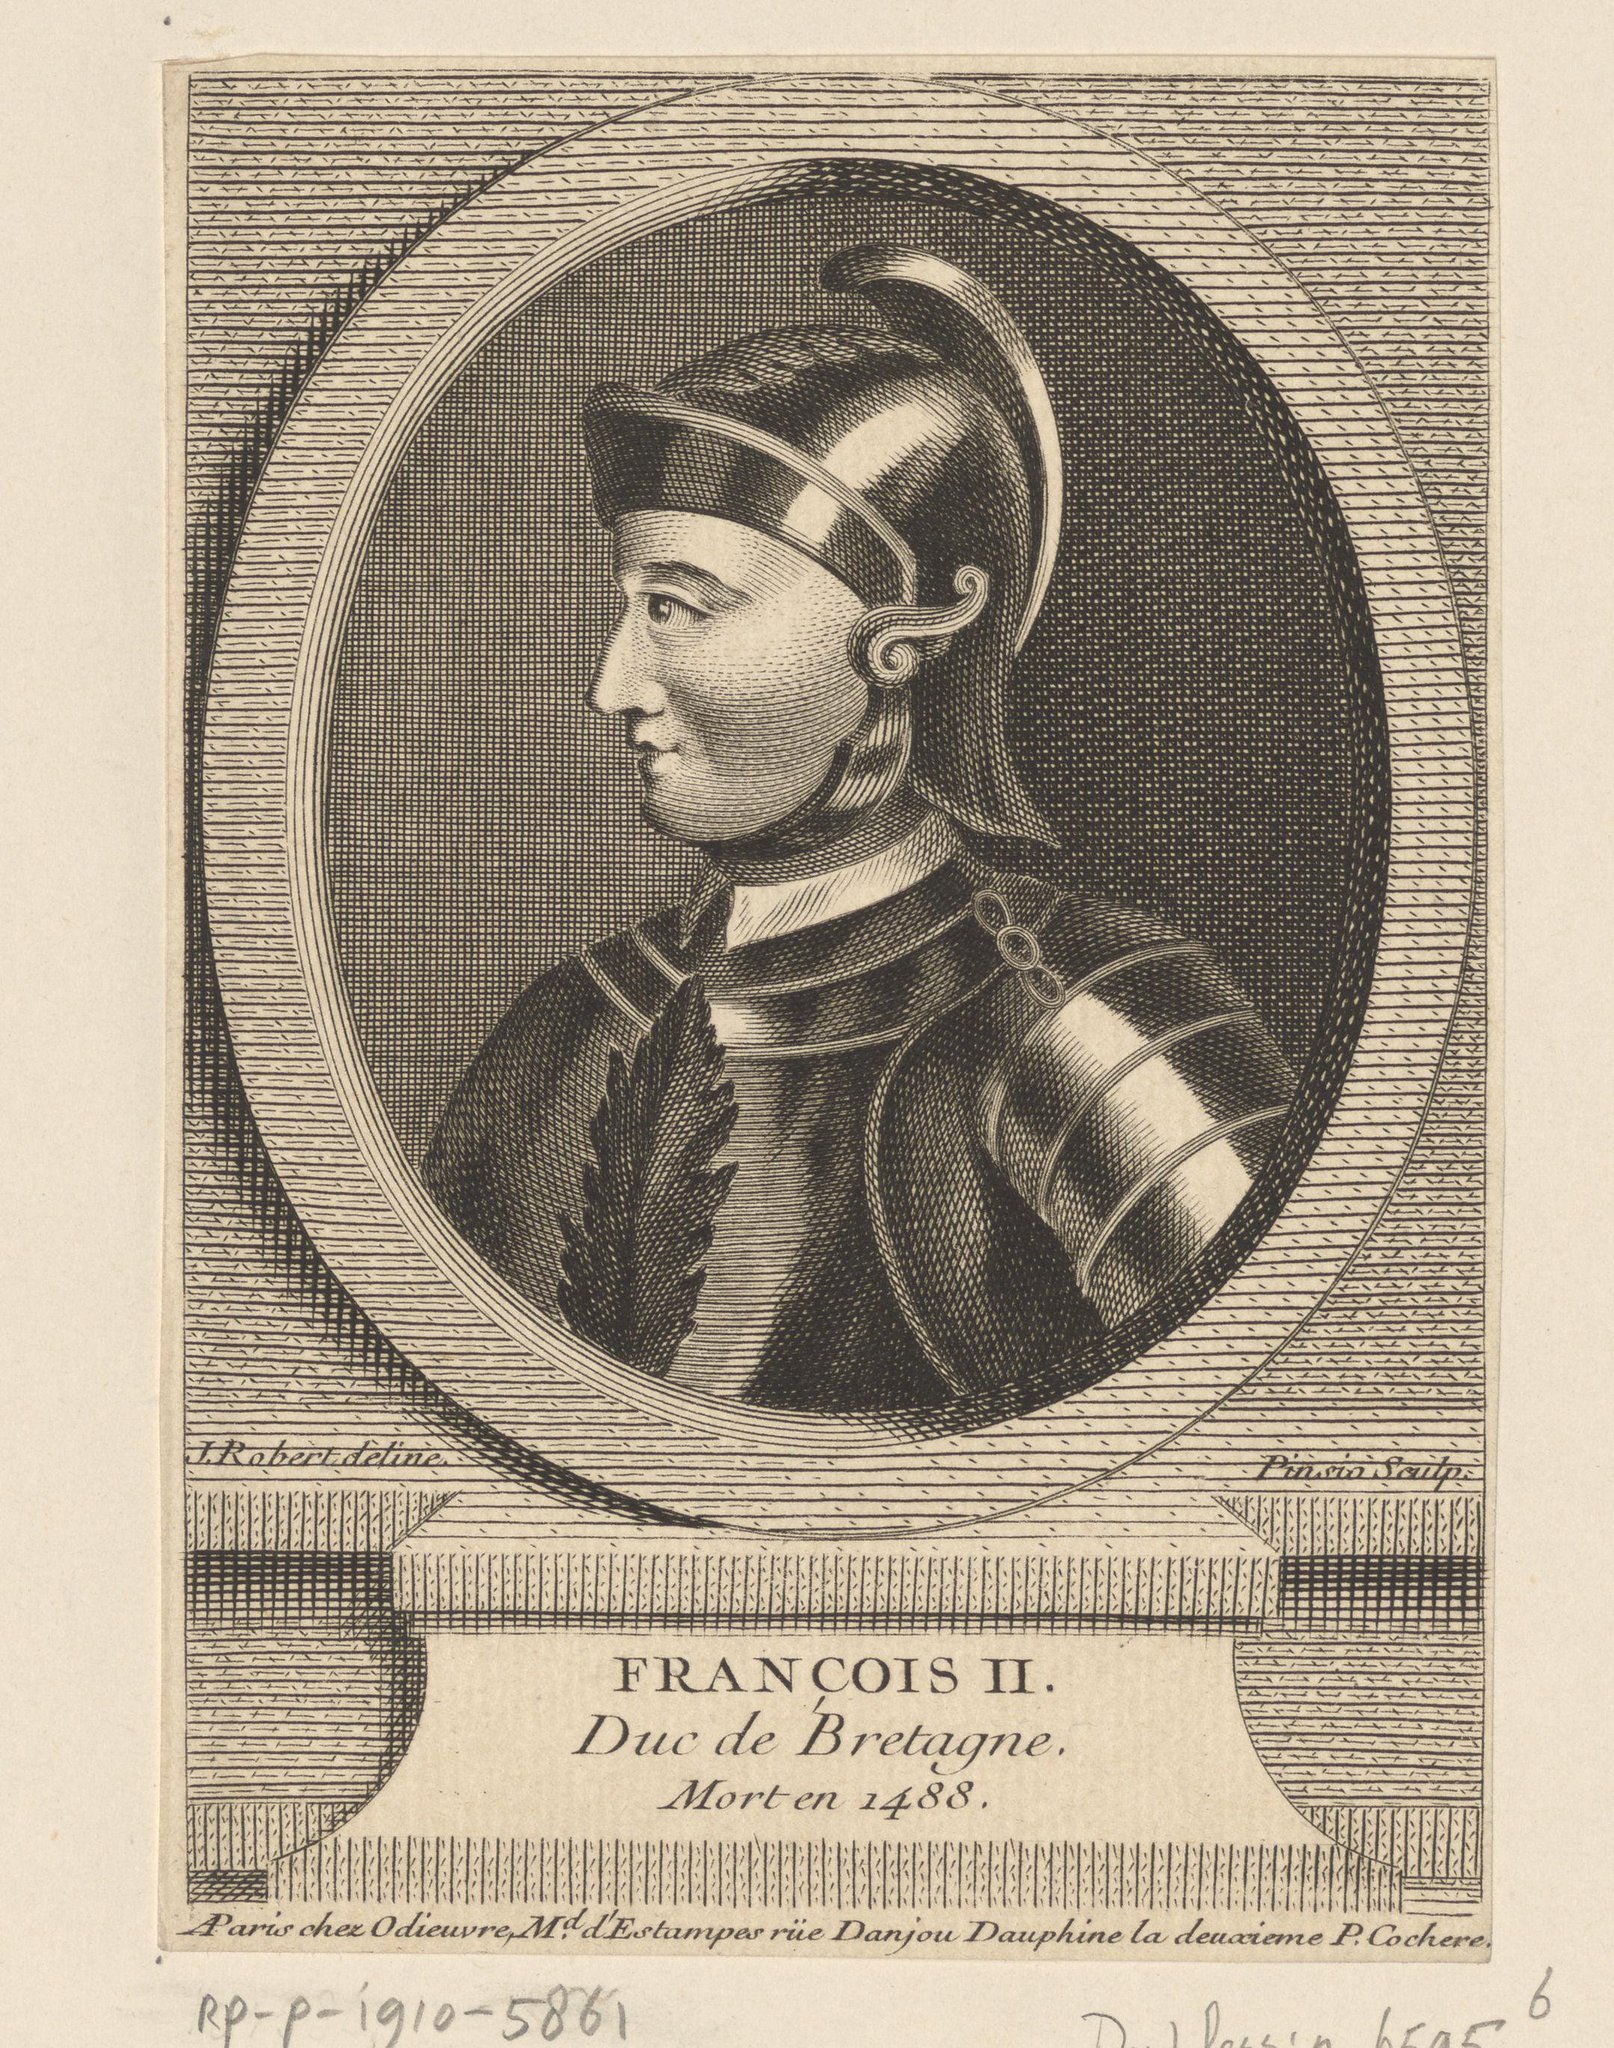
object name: book illustration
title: Portret van Frans II van Bretagne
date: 1755-1765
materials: paper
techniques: engraving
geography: paris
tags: armour, historical persons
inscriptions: collector's mark: Lugt 2228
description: Prent waarschijnlijk uit een deel van: Dreux du Radier, Jean-François. L'Europe illustré, contenant l'histoire abregée des souverains, des princes, des prélats, des ministres, (...) en Europe: dans le XVe. siècle compris, jusqu'à présent. Parijs: Michel Odieuvre en André-François Le Breton, 1755-1765.